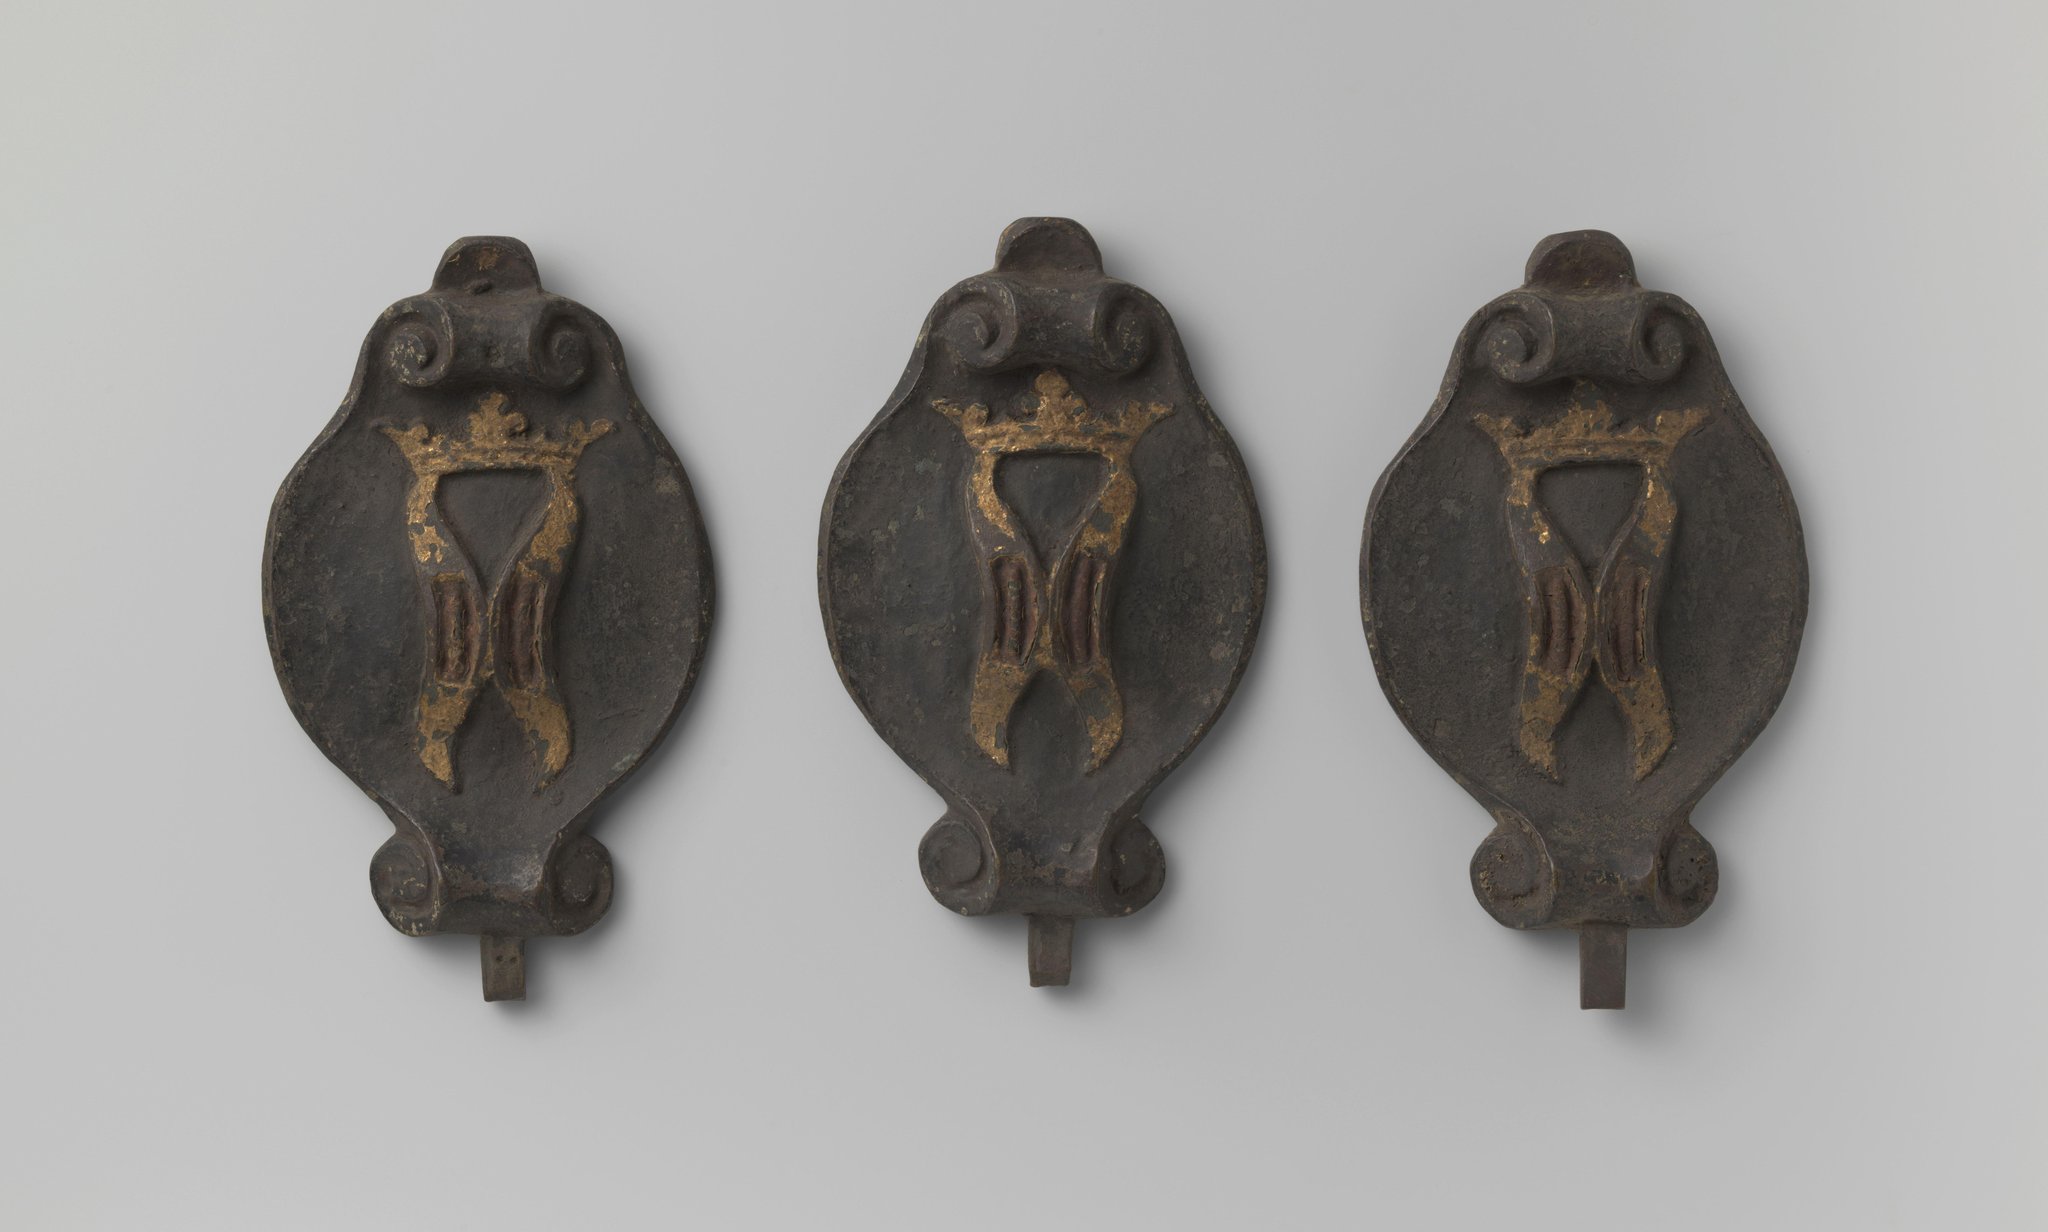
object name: shield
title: Drie schilden met een voorstelling van een dubbele, gekroonde weversspoel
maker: Anonymous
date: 1625-1675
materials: brass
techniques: casting, gilding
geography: netherlands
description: De schilden hebben een breed veld met rolwerk boven- en onderaan. Op het veld zijn twee vergulde weversspoelen weergegeven met daarboven een vergulde driebladige kroon.